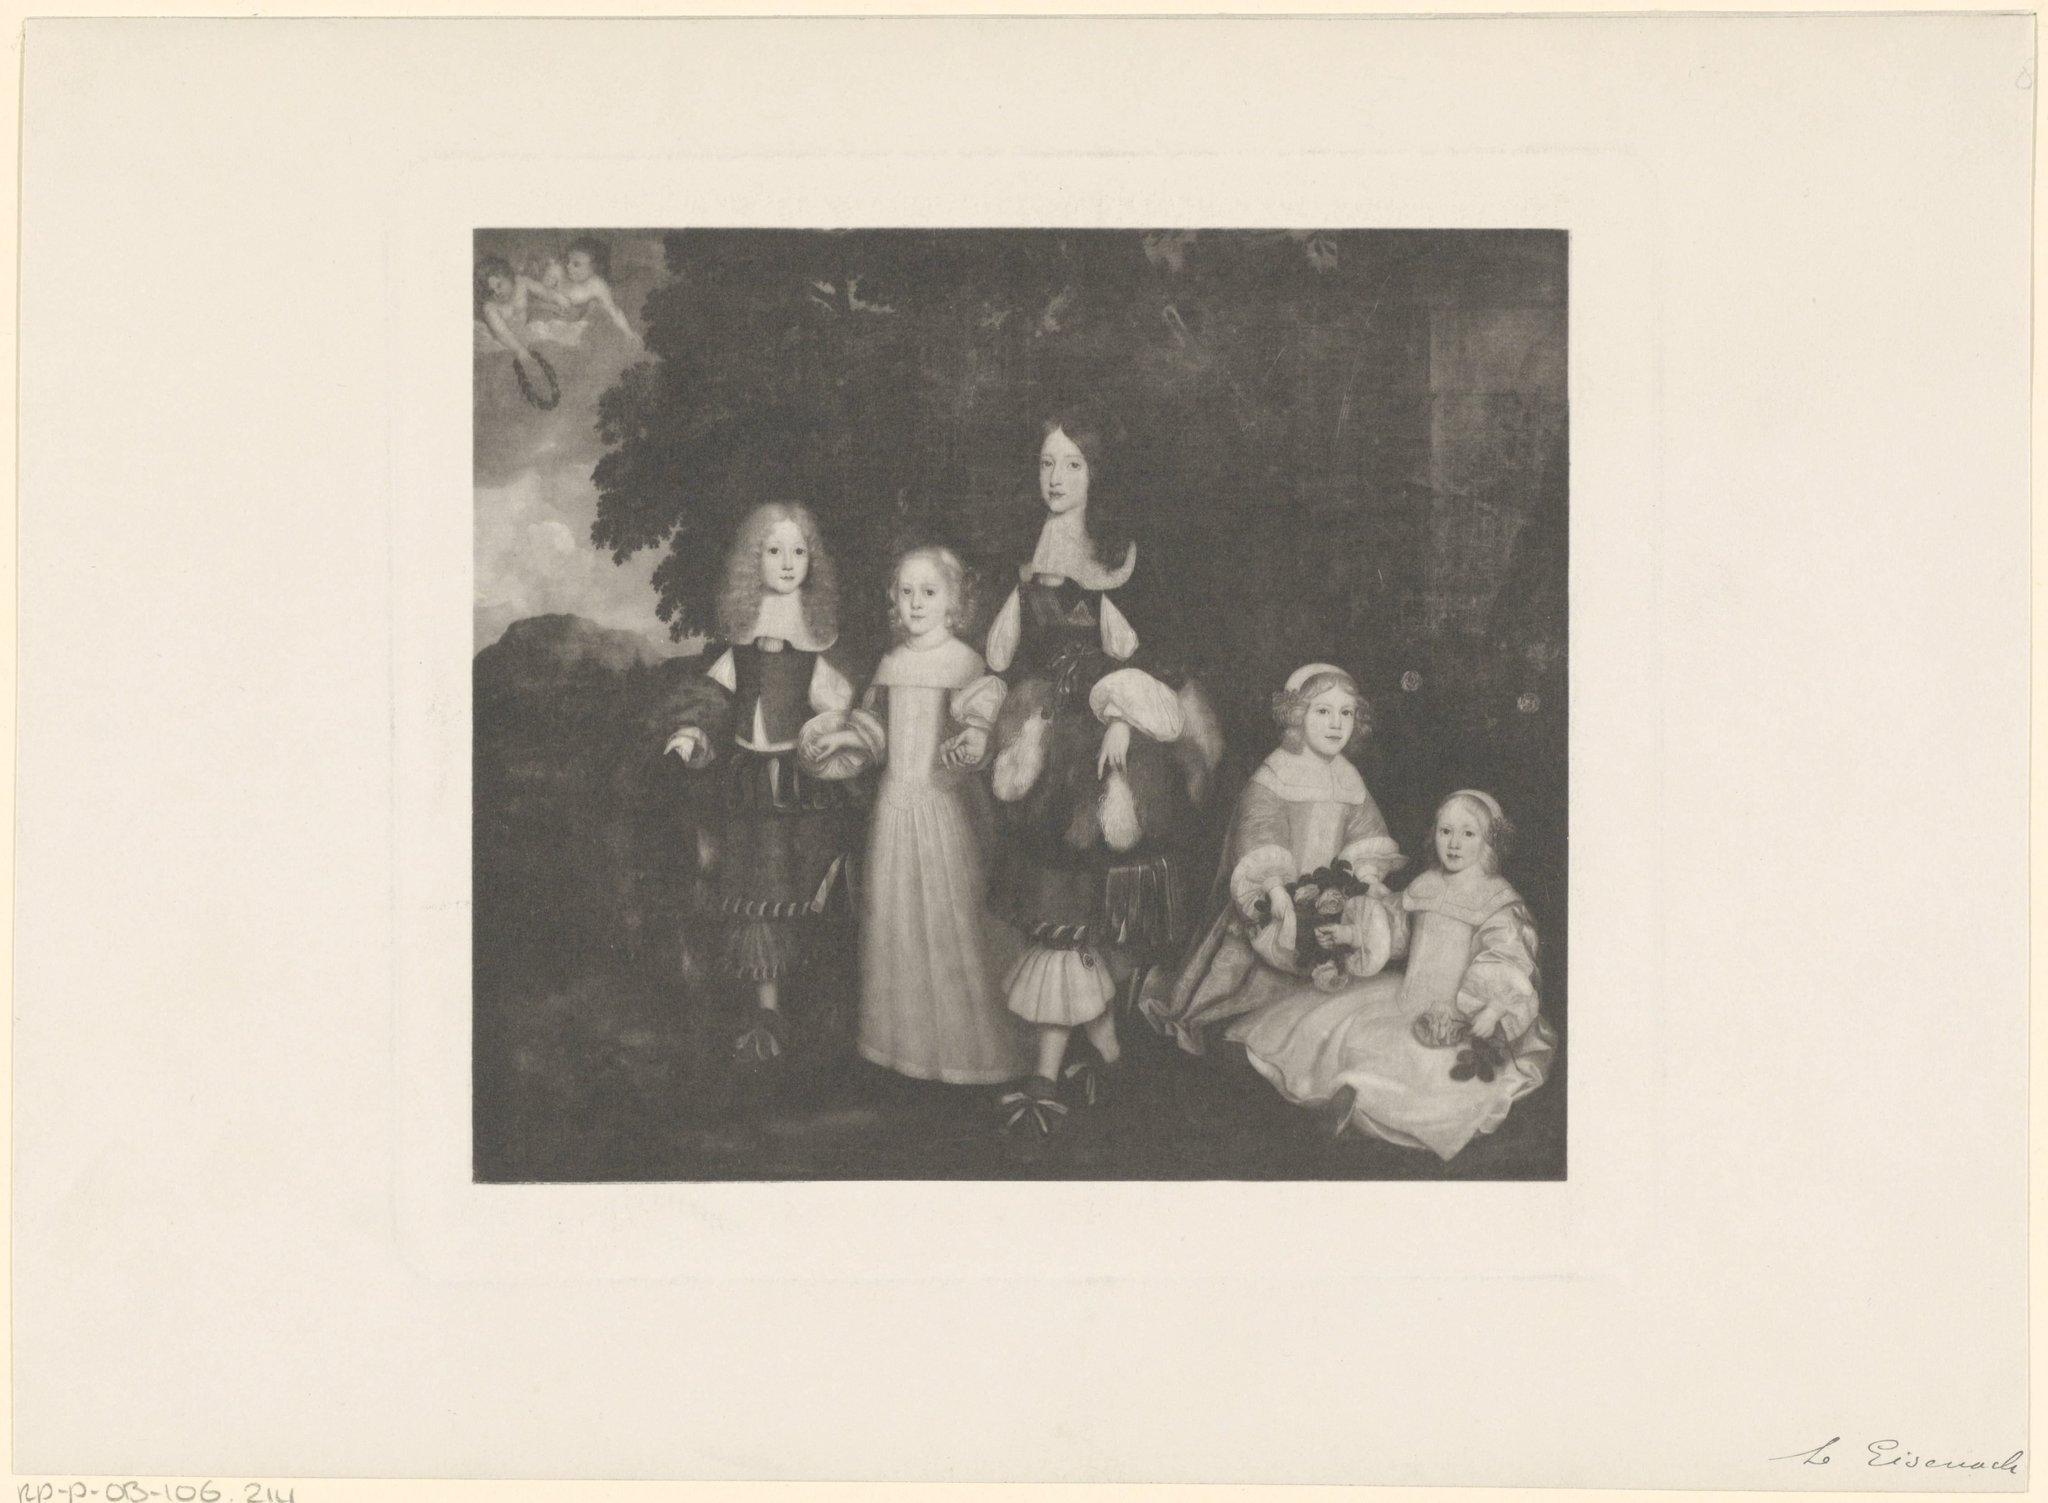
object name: photomechanical print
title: Familieportret van Karel Emil van Brandenburg, Amalia, gravin van Nassau-Dietz, Willem III, prins van Oranje, Hendrik Casimir II, graaf van Nassau-Dietz, en Frederik I, koning van Pruisen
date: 1850-1949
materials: paper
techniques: photograph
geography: netherlands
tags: the hague, william iii (prince of orange and king of england, scotland, and ireland), hendrik casimir ii graaf van nassau-dietz, berlin, frederik i koning van pruisen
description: De hier vermelde titel verwijst naar de hoogst verkregen titel van de geportretteerde, niet per se naar de titel die de geportretteerde op deze voorstelling draagt.